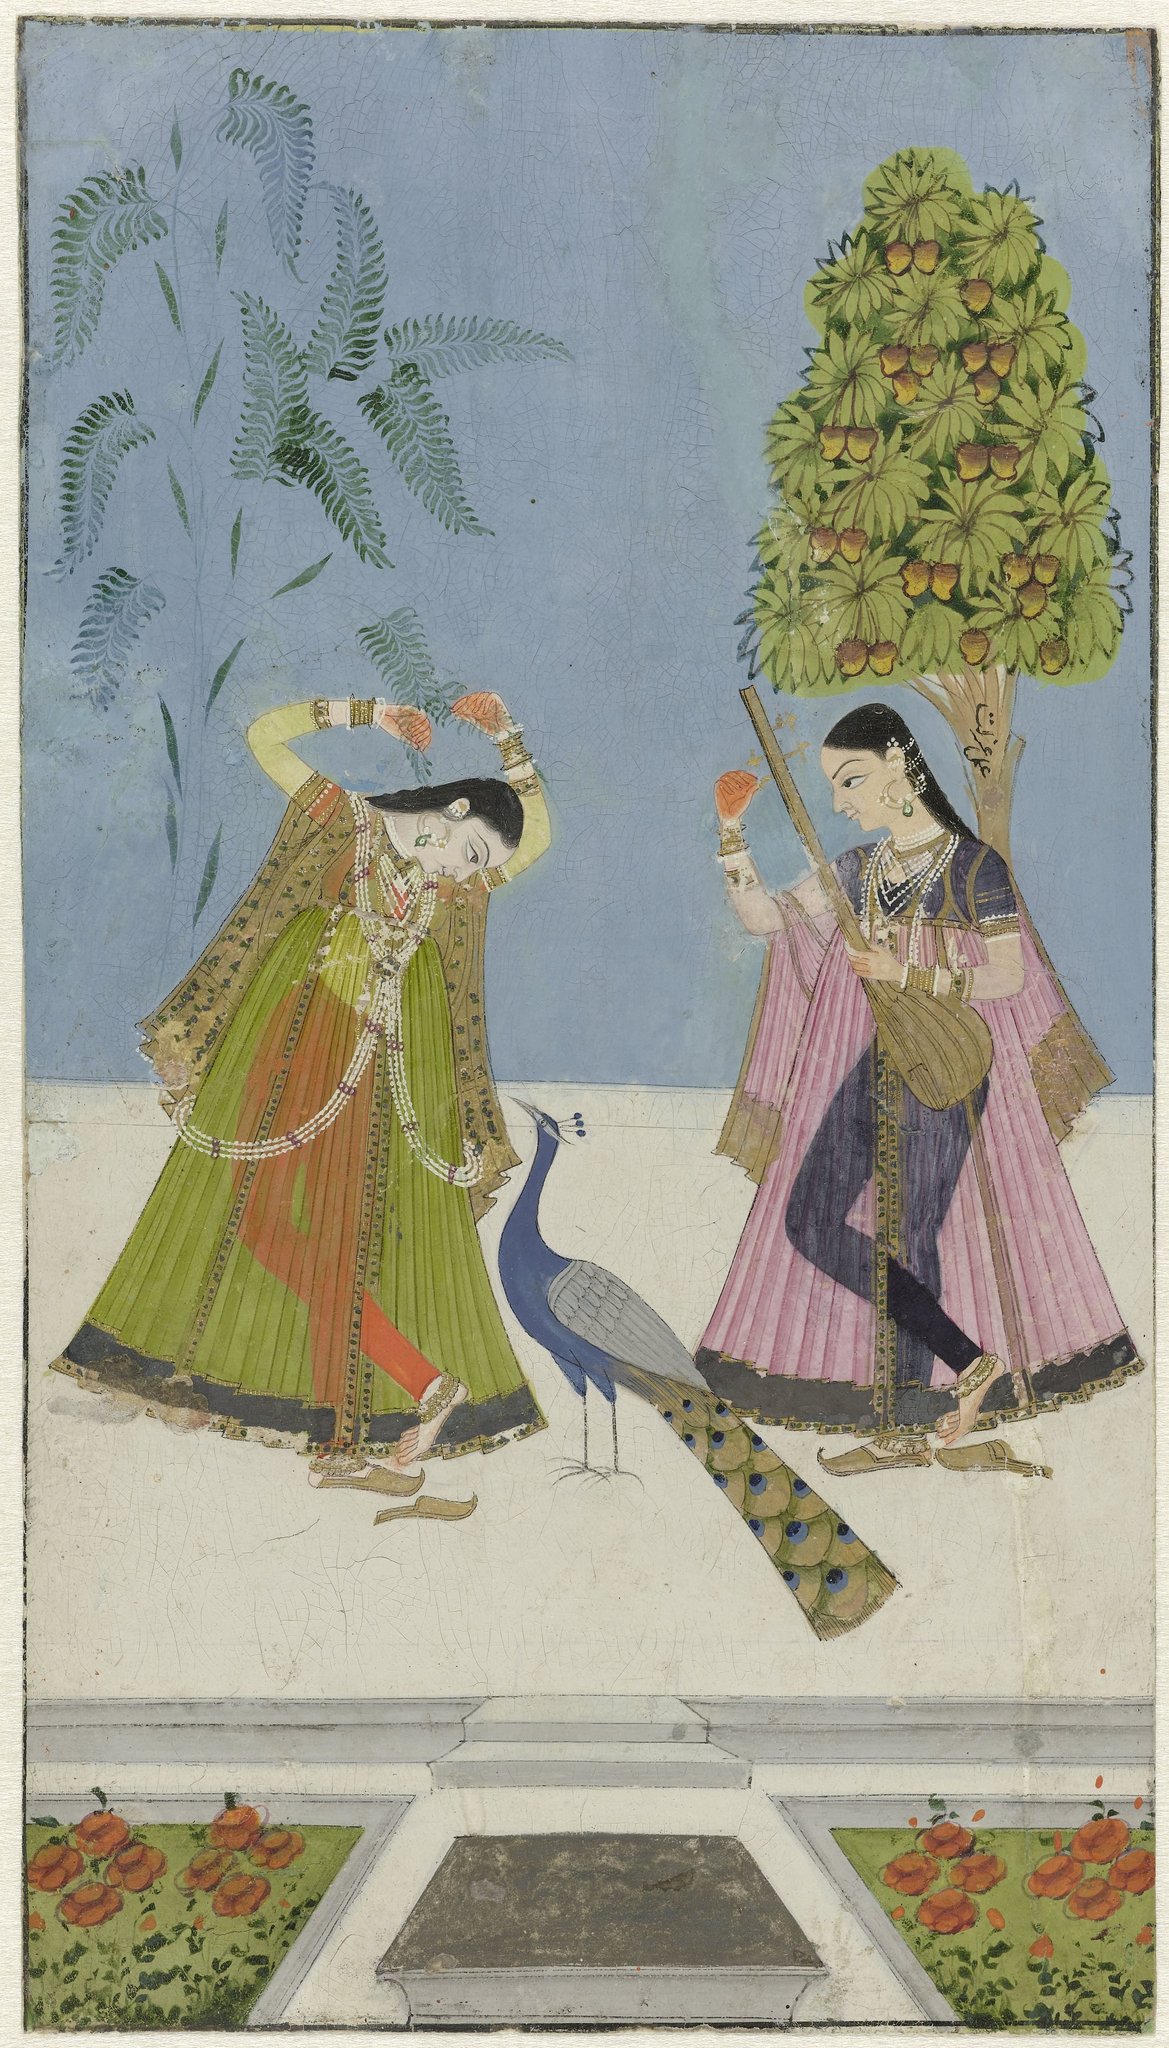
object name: drawing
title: Twee vrouwen en een pauw, Gujara Ragini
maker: Anonymous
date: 1780-1799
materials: gouache, paper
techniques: brush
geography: shorapur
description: Twee vrouwen staan ieder onder een boom. De rechter stemt de tanpura onder een vruchtdragende mango-boom. De linker houdt zich aan de twijg van een boom vast, terwijl ze naar een pauw kijkt.